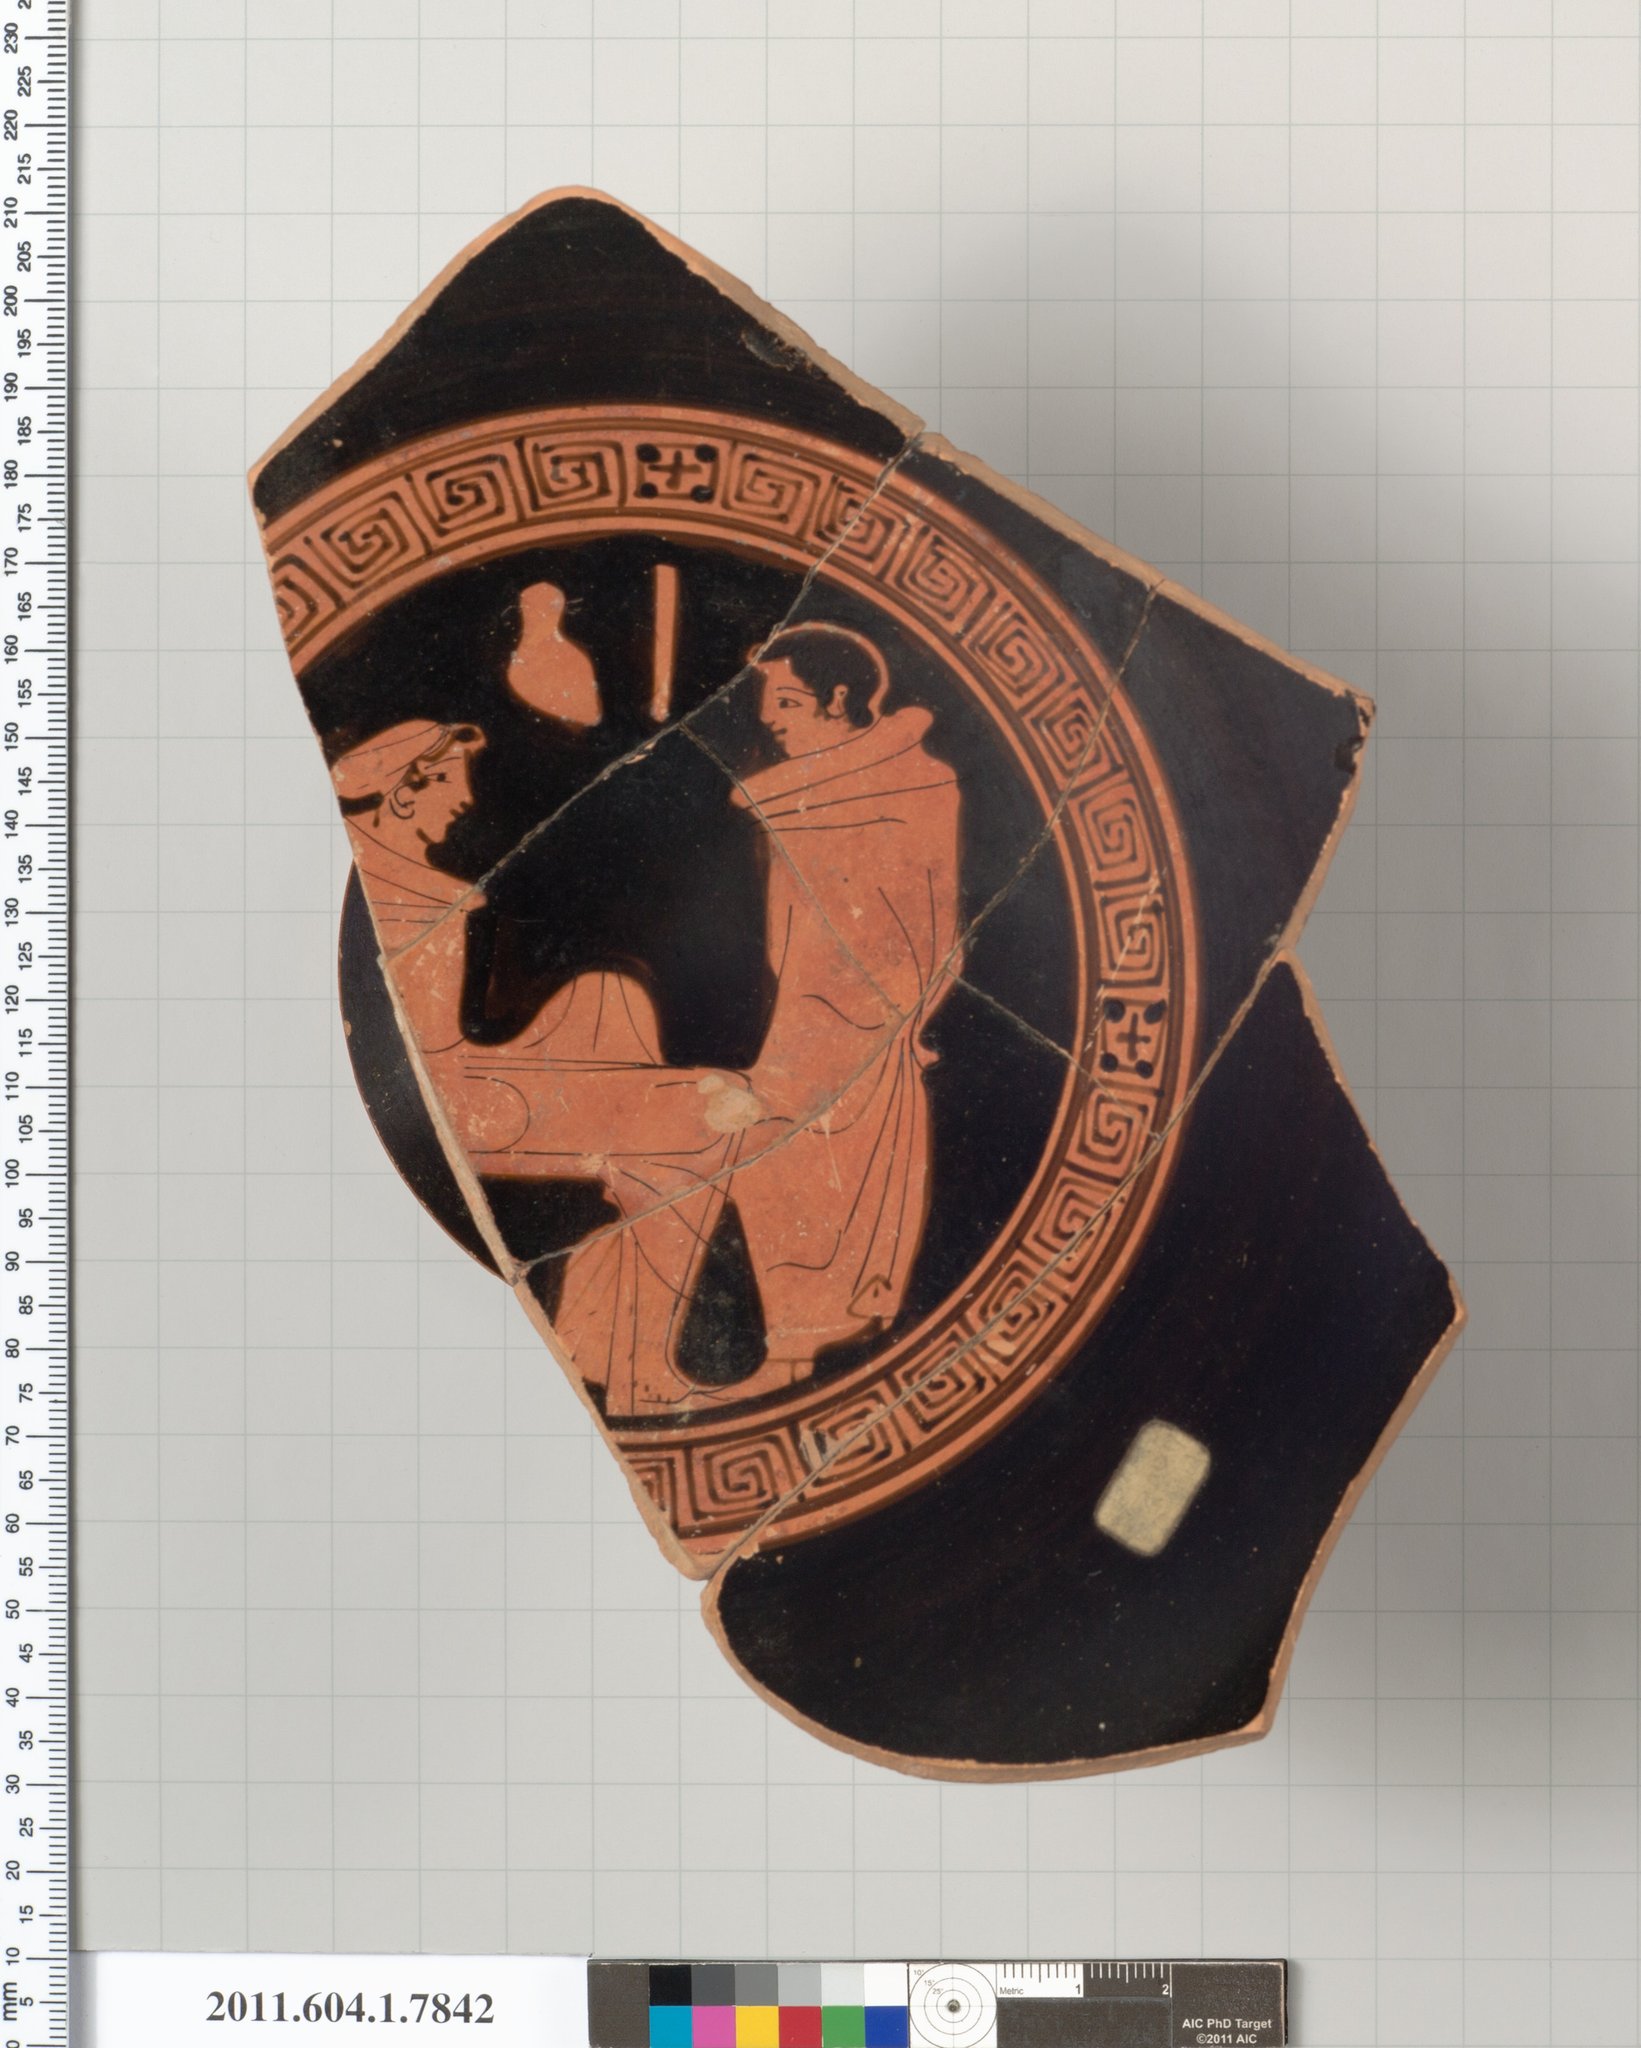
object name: kylix fragment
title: Terracotta fragment of a kylix (drinking cup)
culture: greek, attic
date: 475-451 BCE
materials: terracotta